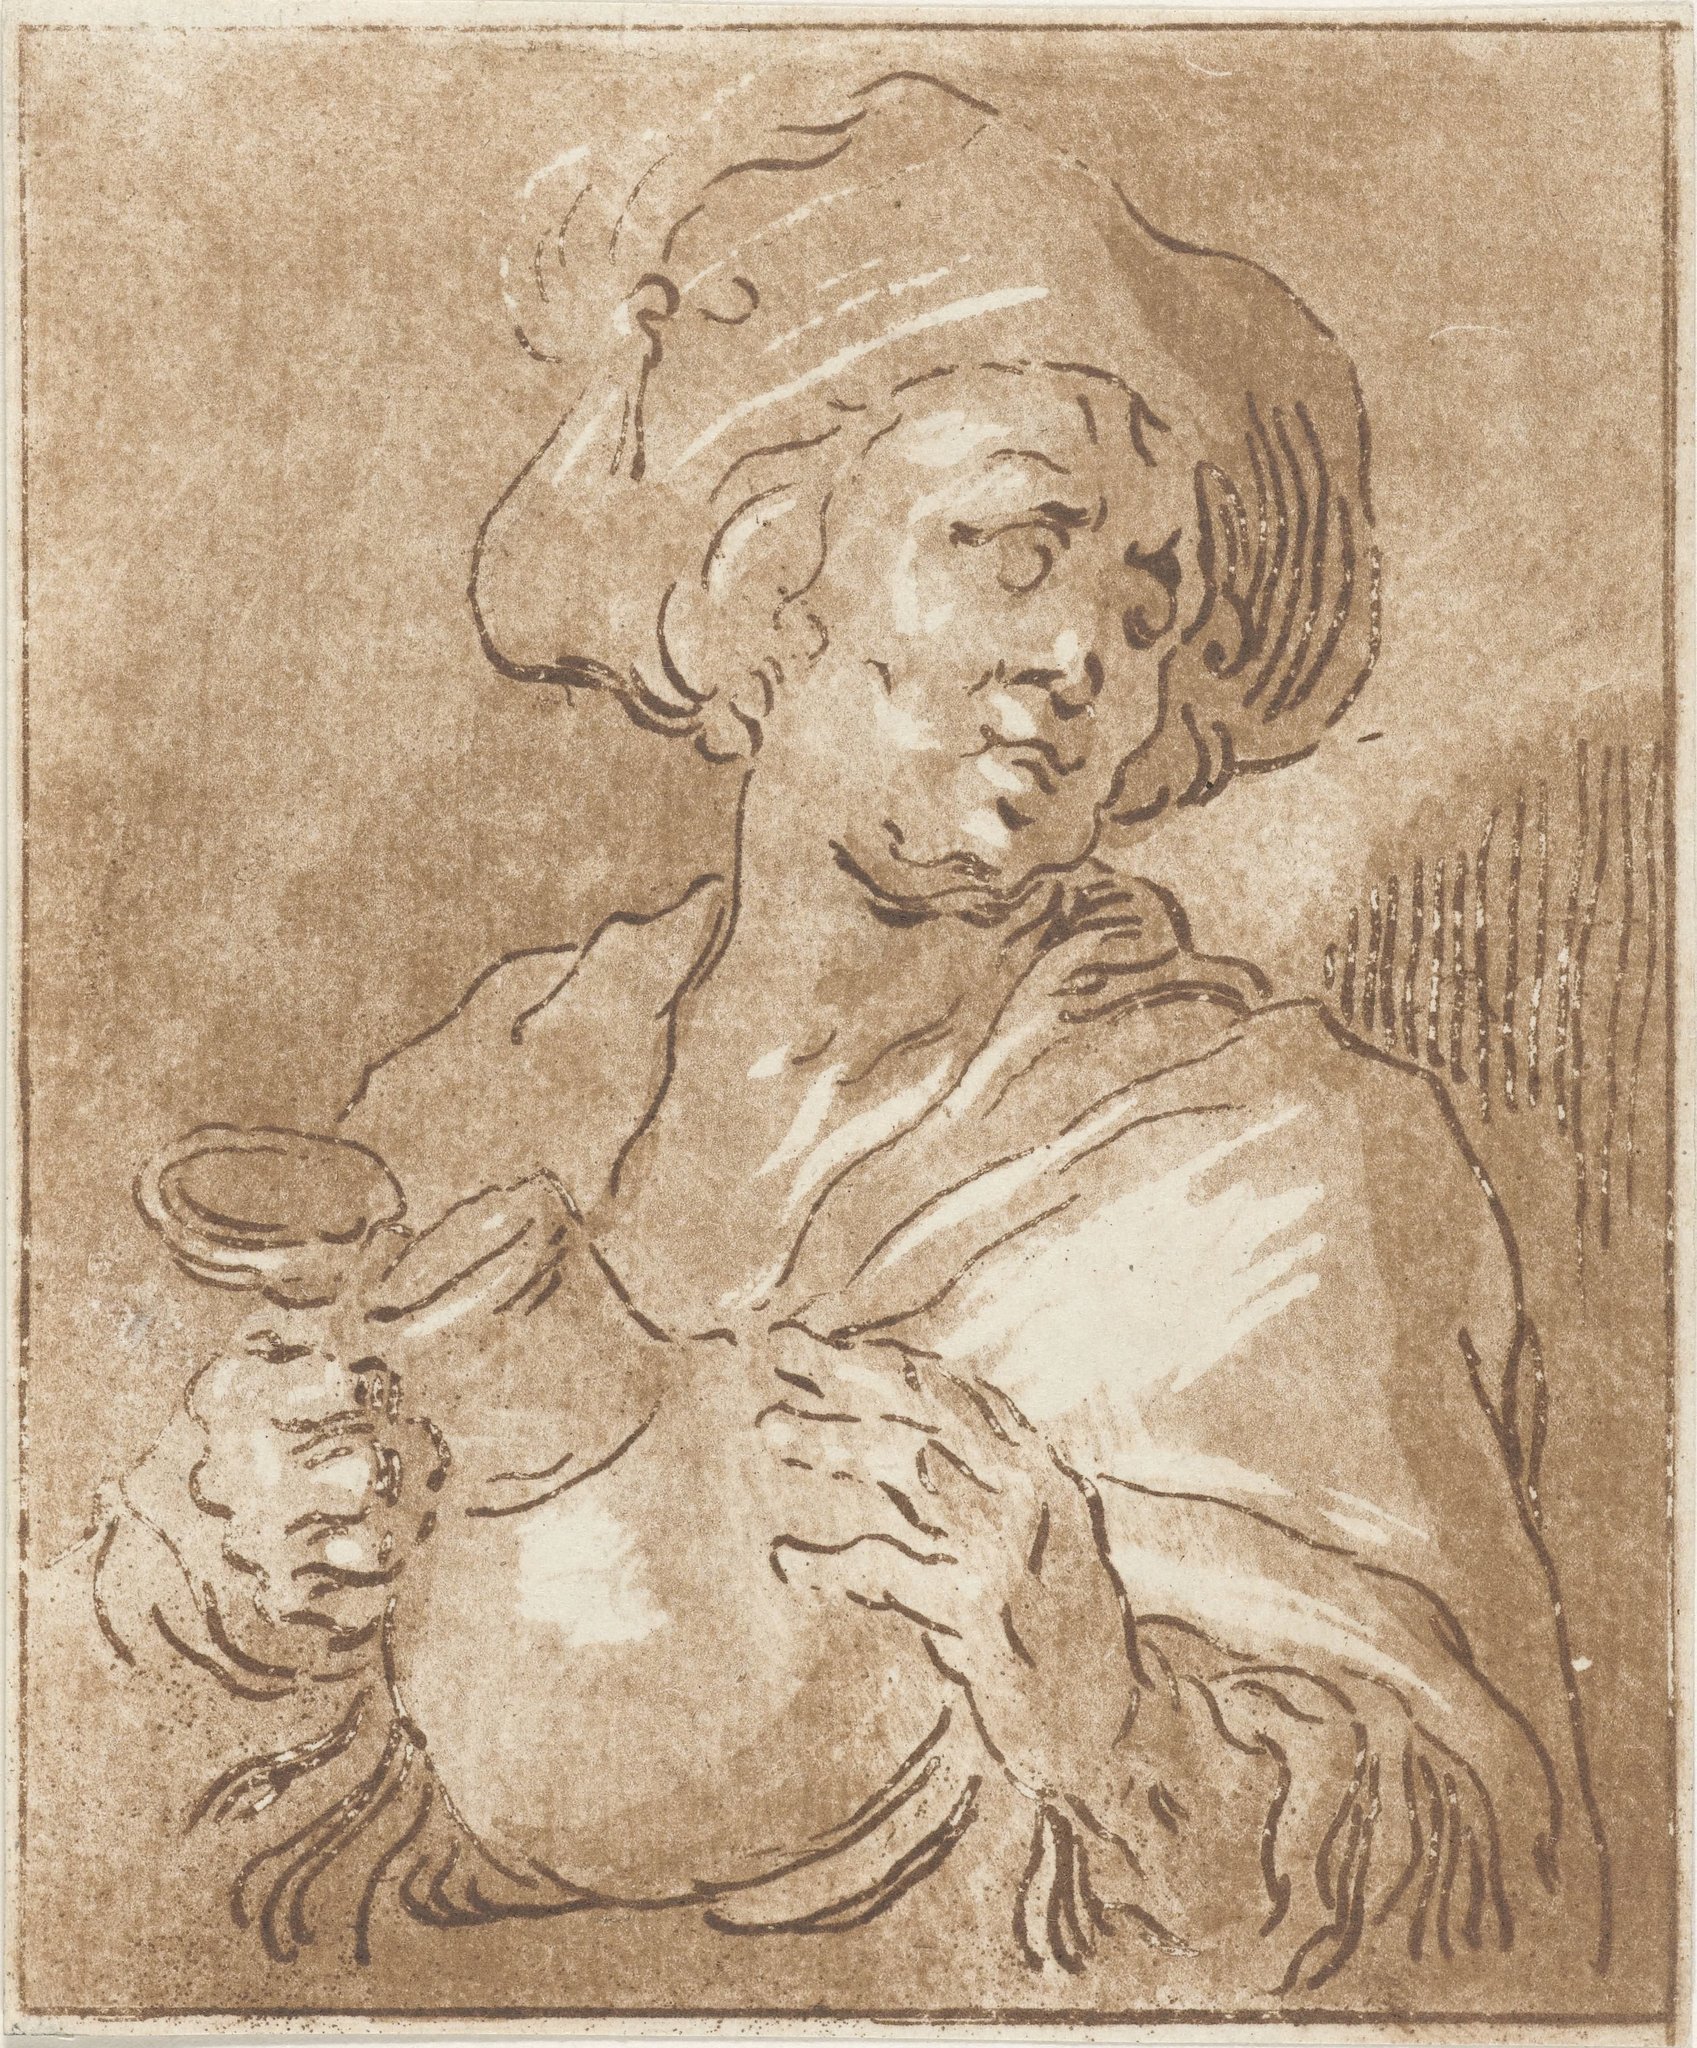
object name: print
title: Man met kruik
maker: hermanus fock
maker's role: conservator, draughtsman, painter, print maker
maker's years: 1766-1822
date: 1781-1822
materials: paper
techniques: aquatint, etching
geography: netherlands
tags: jar, jug (used as drinking-vessel)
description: Figuur, ten halven lijve, met gevederde hoed op het hoofd en een bierkruik in beide handen.